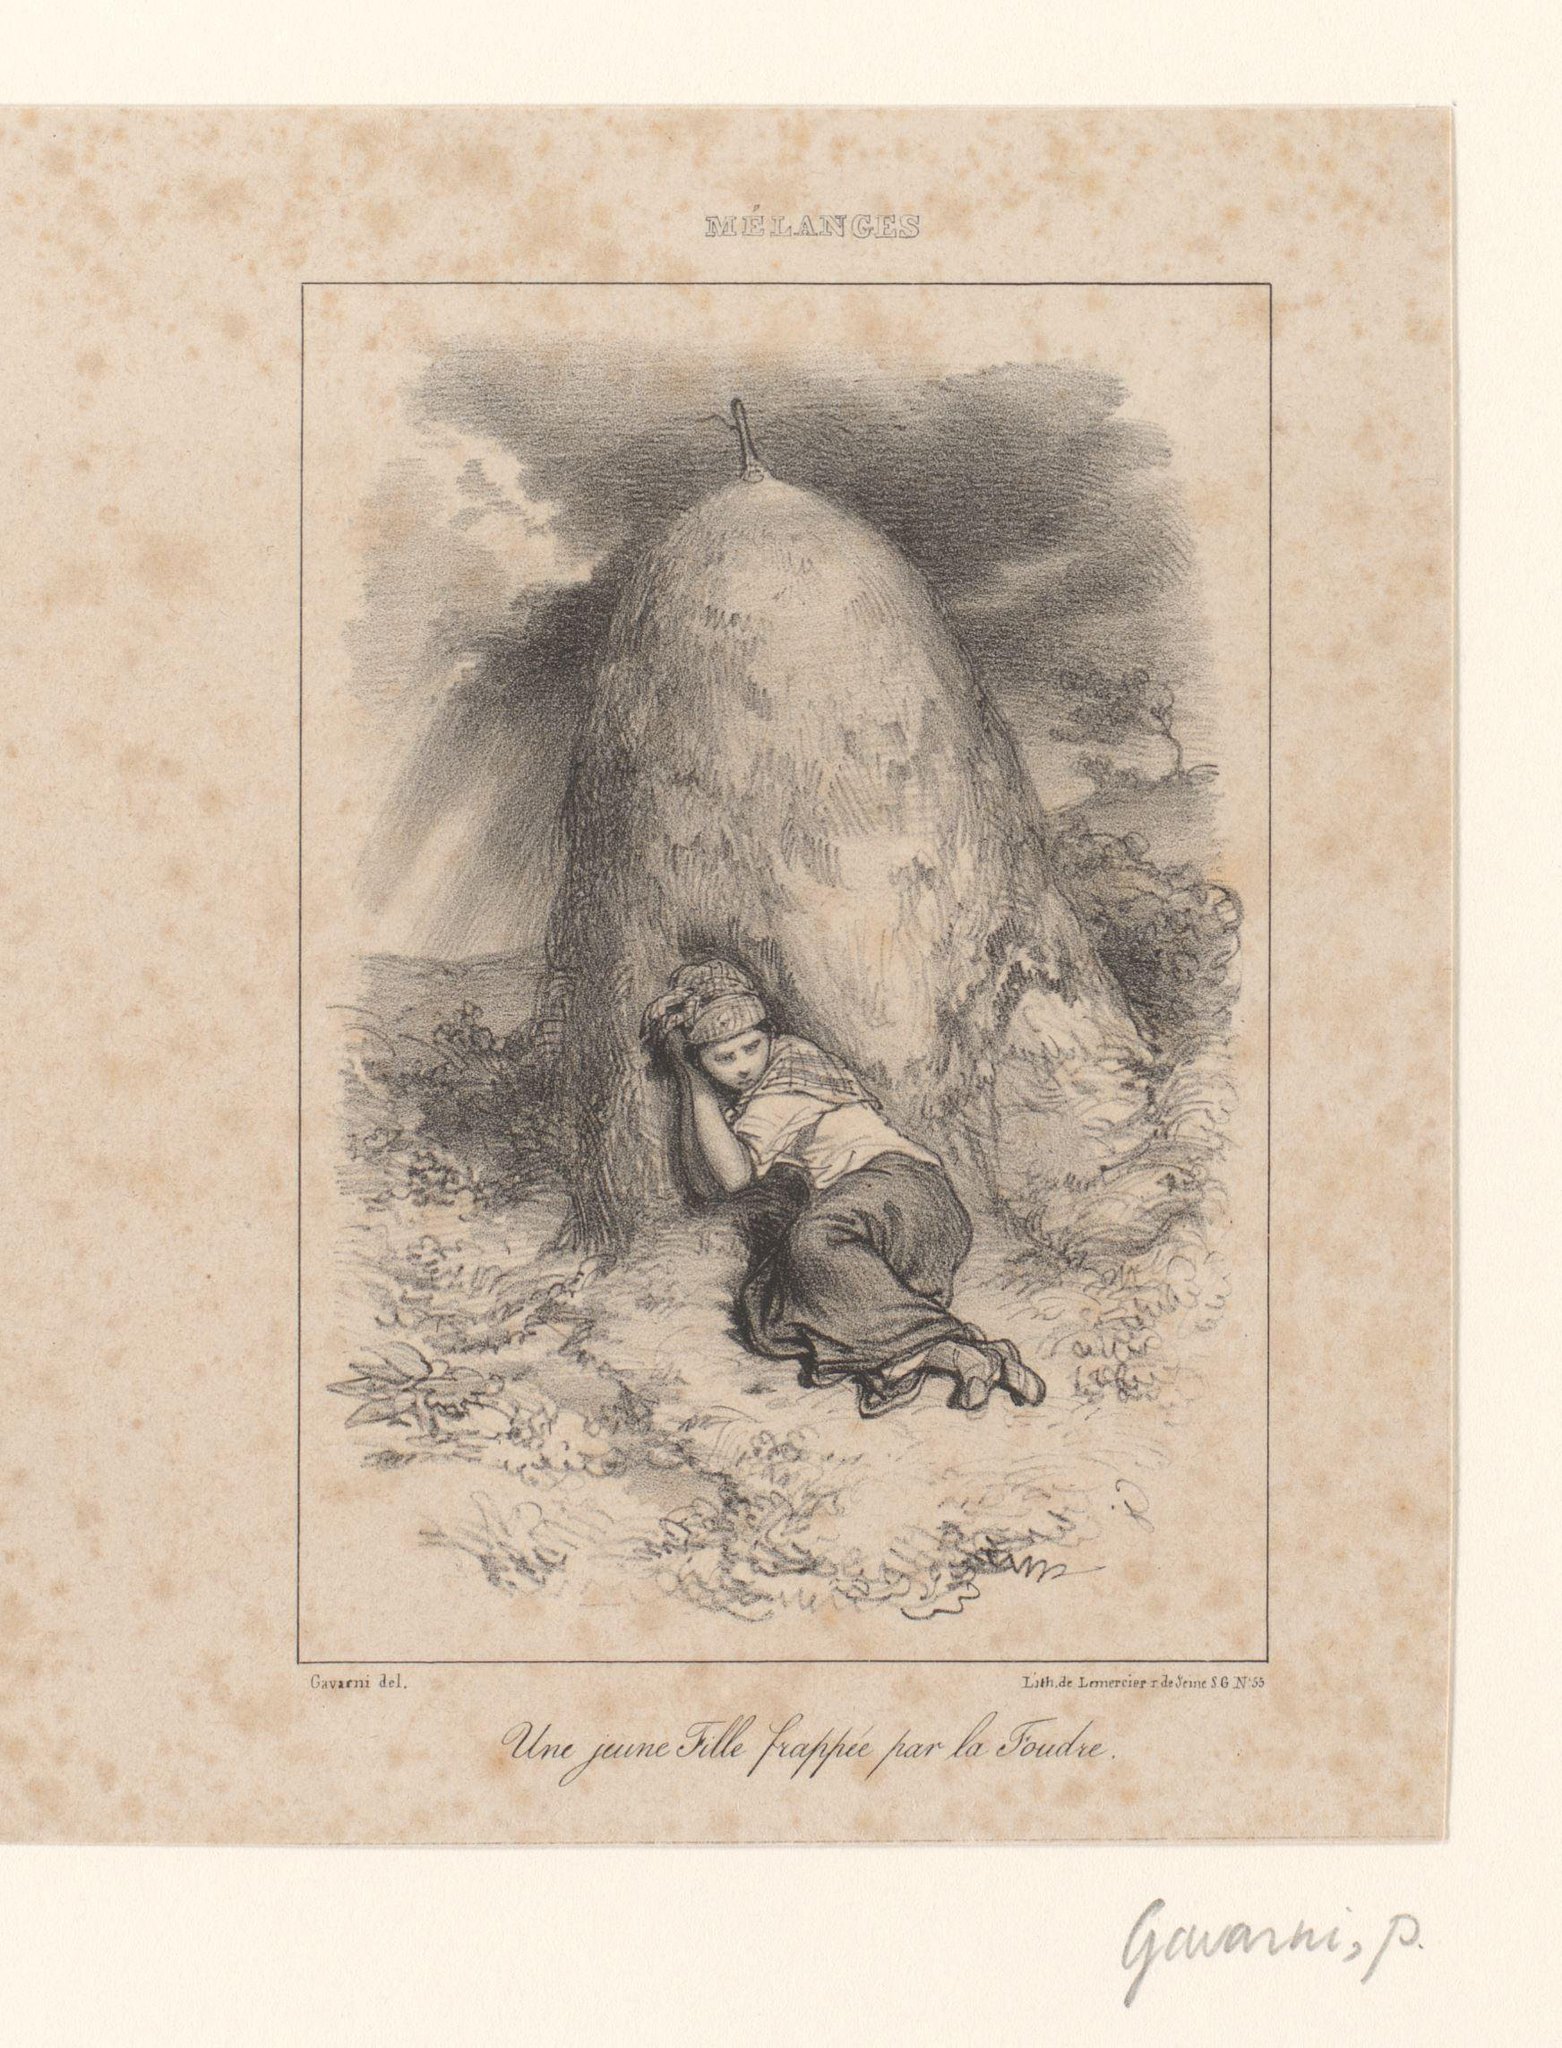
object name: print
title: Modes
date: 1835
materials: paper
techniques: lithograph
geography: paris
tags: boy (child between toddler and youth), resting - bb - out of doors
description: Prent gebruikt voor: Le Courrier des enfants, 25 augustus 1835.